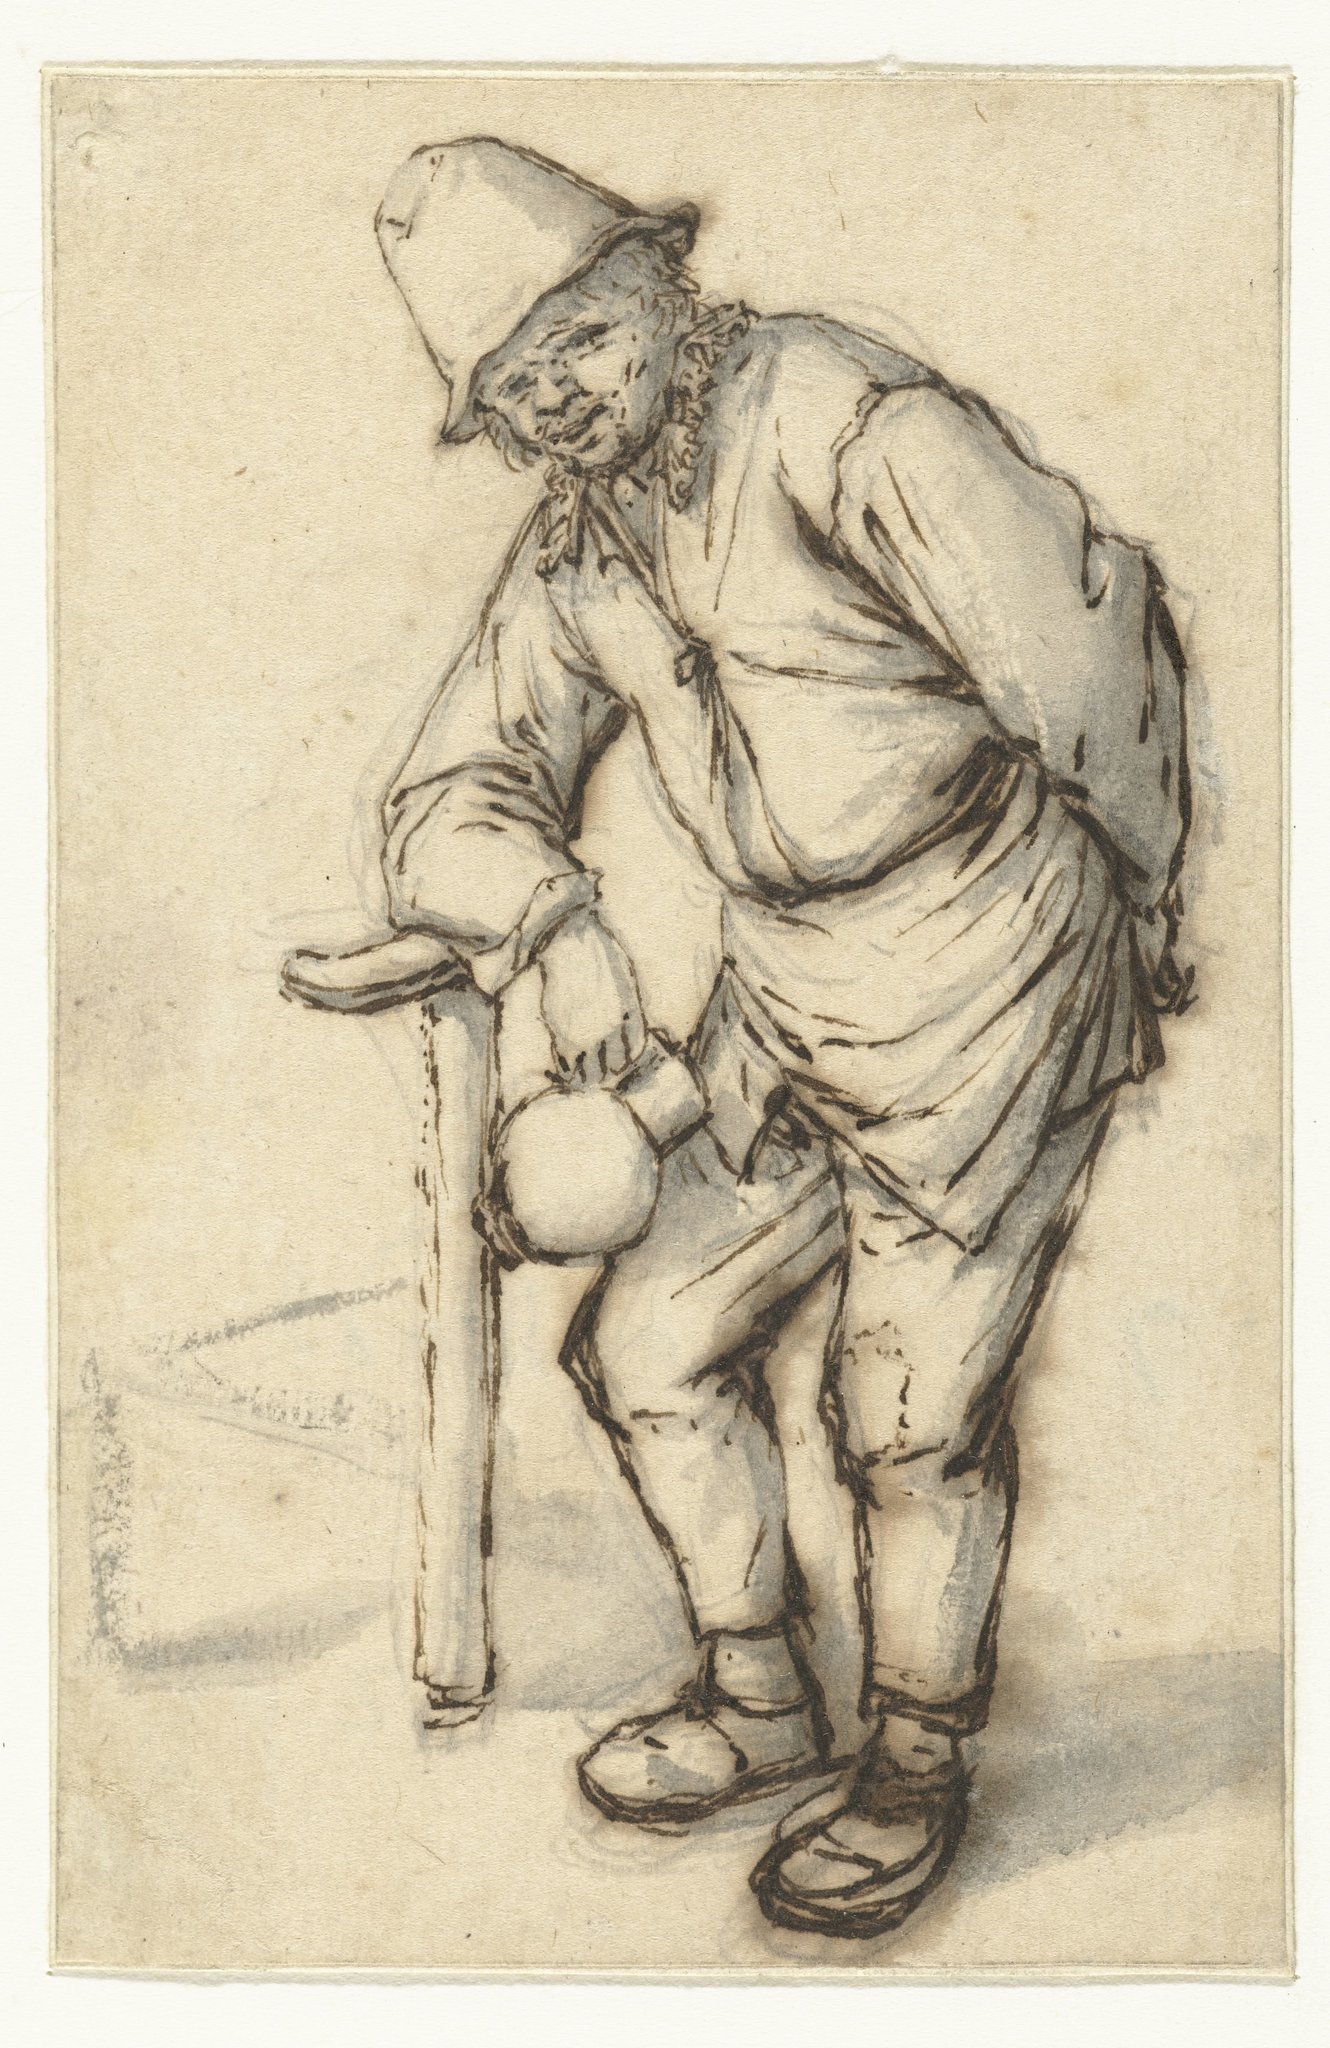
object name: drawing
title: Mansfiguur, leunend op een stoel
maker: adriaen van ostade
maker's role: draughtsman, painter, print maker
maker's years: 1610-1685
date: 1670-1685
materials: ink, paper, pencil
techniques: brush, pen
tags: leaning figure